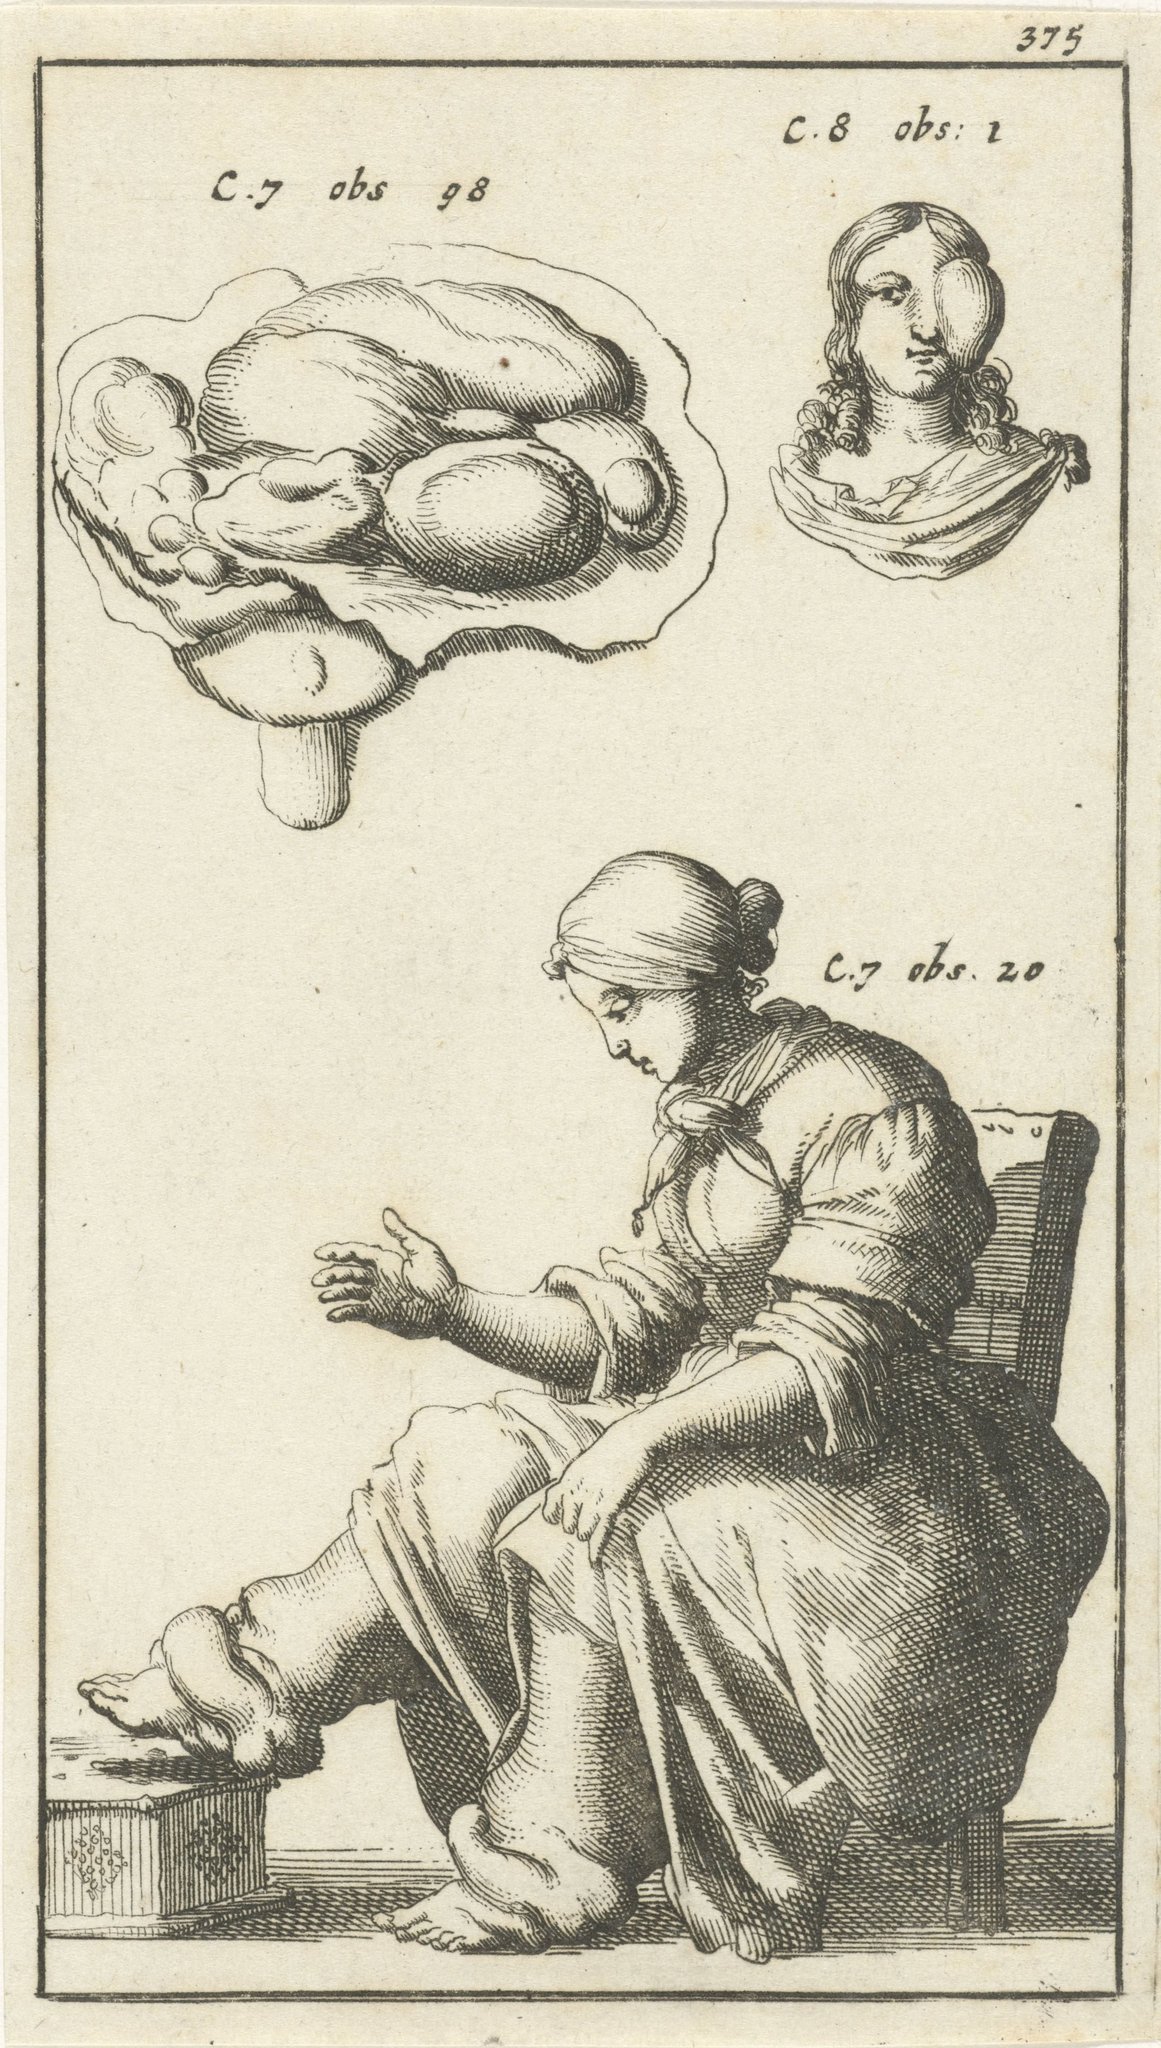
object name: print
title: Anatomische afbeelding XX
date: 1680-1688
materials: paper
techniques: etching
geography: amsterdam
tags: biology, anatomical models (usually series of five figures)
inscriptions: collector's mark: Lugt 2228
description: Illustratie opgenomen in: Blankaart, Steven. Collectanea medico-physica, oft Hollands jaar-register der genees- en natuur-kundige aanmerkingen, 3 delen, dl. II, fol. 375. Amsterdam: Jan Claesz ten Hoorn, 1680-1688.